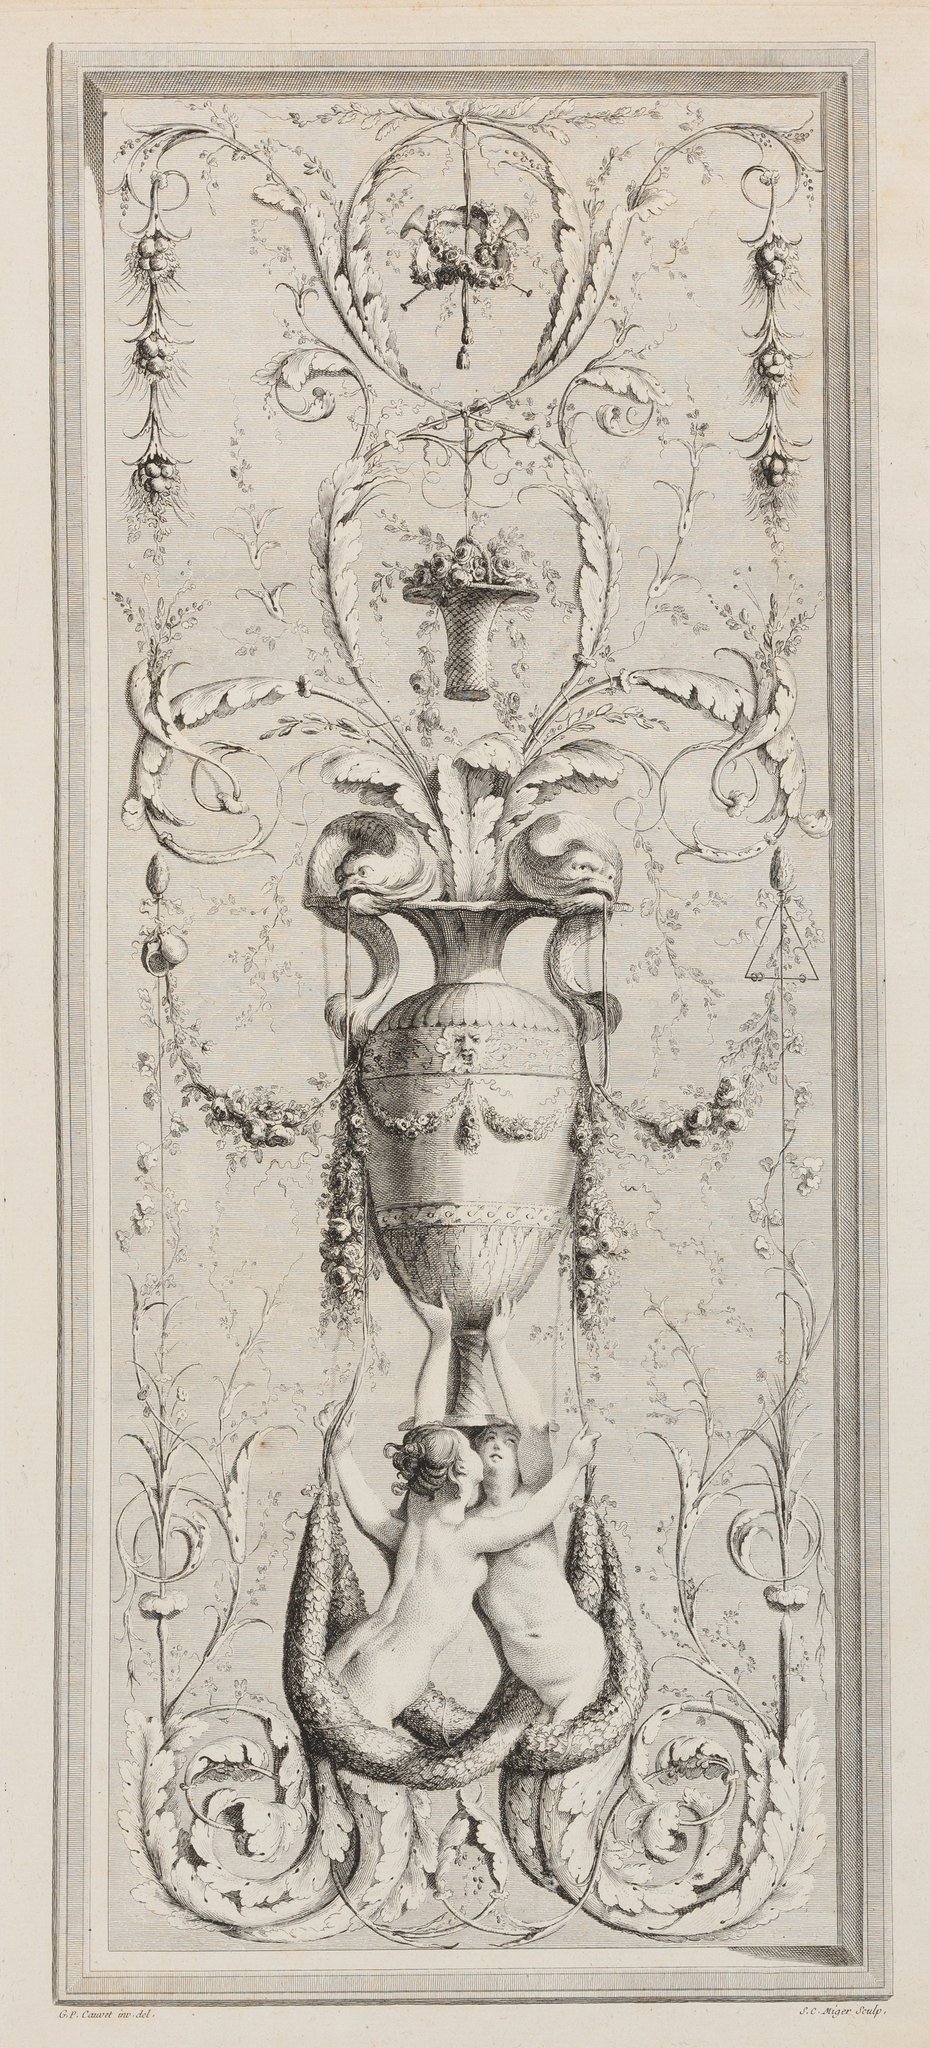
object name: book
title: Recueil d'Ornemens A l'Usage des Jeunes Artistes qui se destinent à la décoration des bâtimens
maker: gilles paul cauvet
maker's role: artist and publisher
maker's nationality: french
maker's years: 1731-1788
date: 1777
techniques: engraving, etching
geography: france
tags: garlands,ornament,female nudes,vases